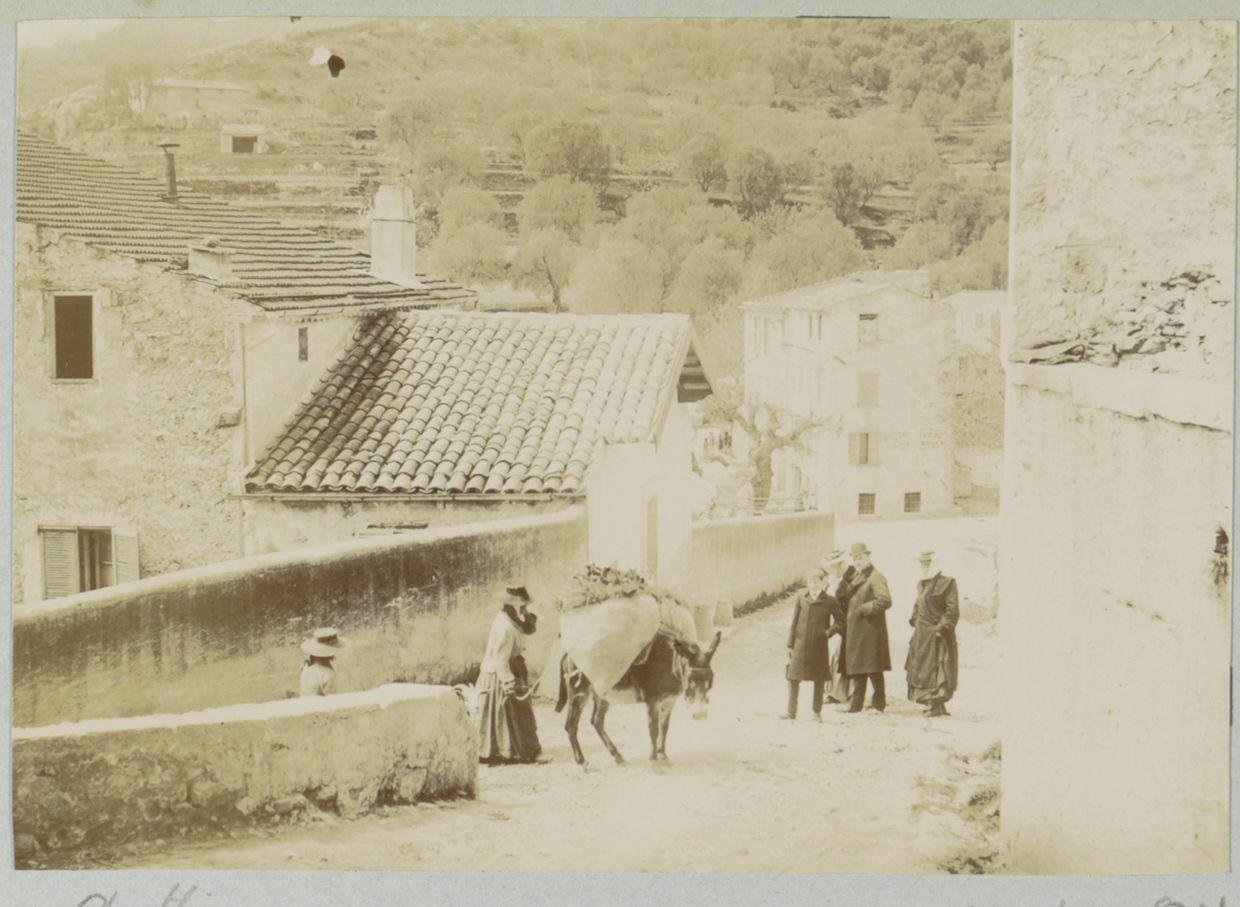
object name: photograph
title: Gezelschap bij een beladen ezel in Gattières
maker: delizy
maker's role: manufacturer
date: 1903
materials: paper, photographic support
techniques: gelatin silver print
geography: gattieres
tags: ass, donkey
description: Onderdeel van Fotoalbum van een Franse amateurfotograaf met opnames van uitstapjes in Frankrijk, Spanje, België, Luxemburg en Nederland, de eerste automobielen en autoraces.